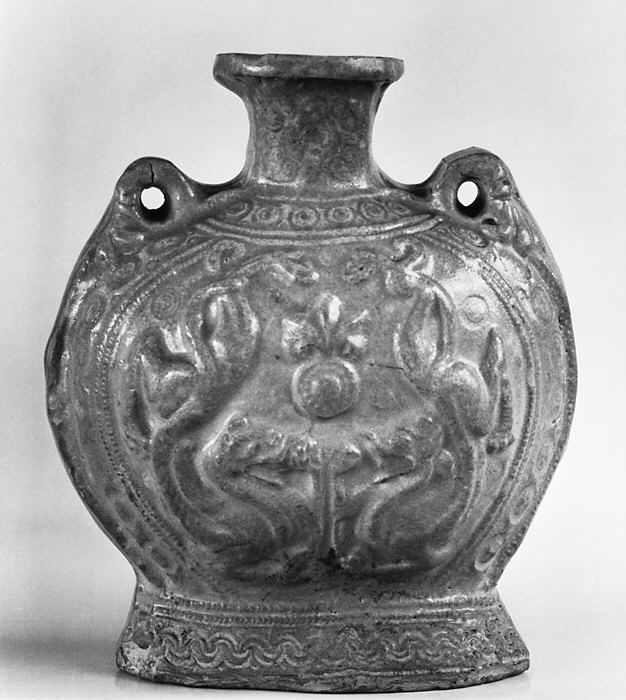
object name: pilgrim bottle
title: Pilgrim bottle with dragons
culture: chinese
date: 567-600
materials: stoneware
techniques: carving, glazing, relief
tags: dragons